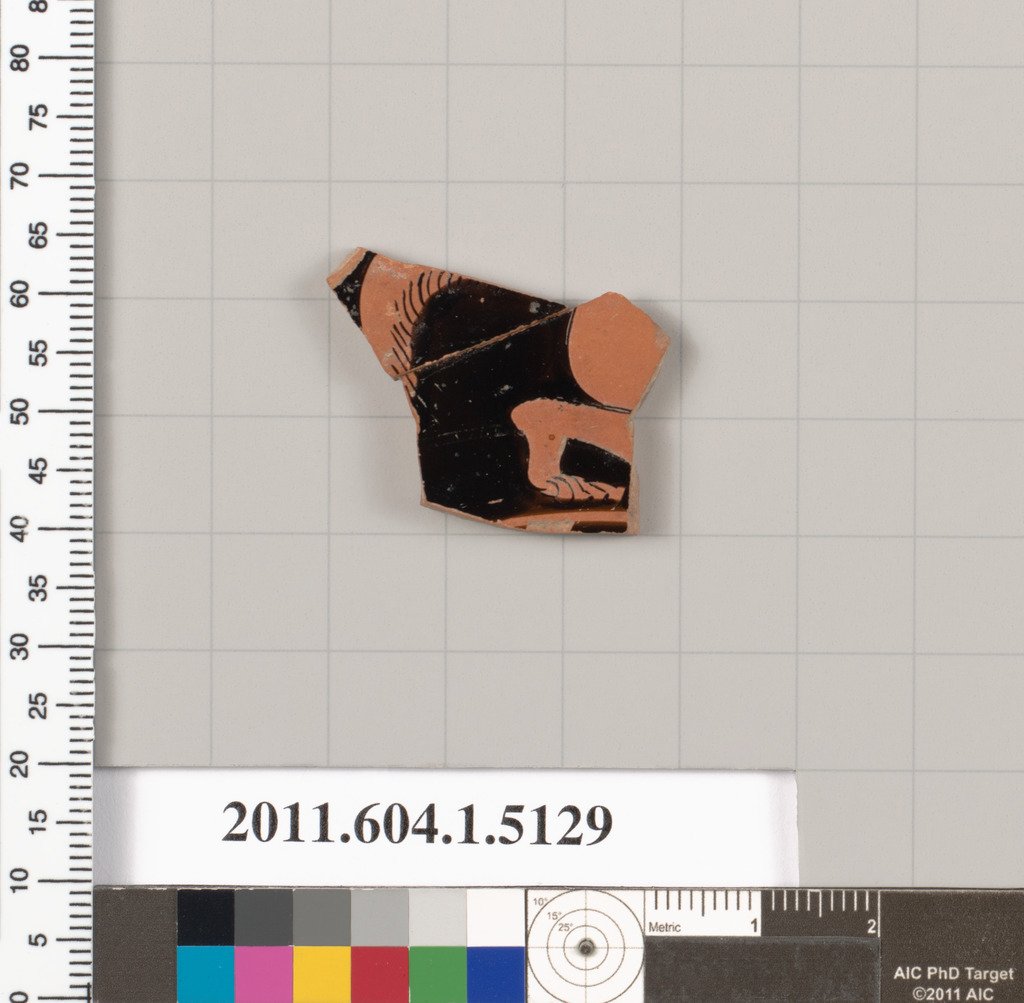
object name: kylix fragment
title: Terracotta fragment of a kylix (drinking cup)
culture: greek, attic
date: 500-480 BCE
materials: terracotta